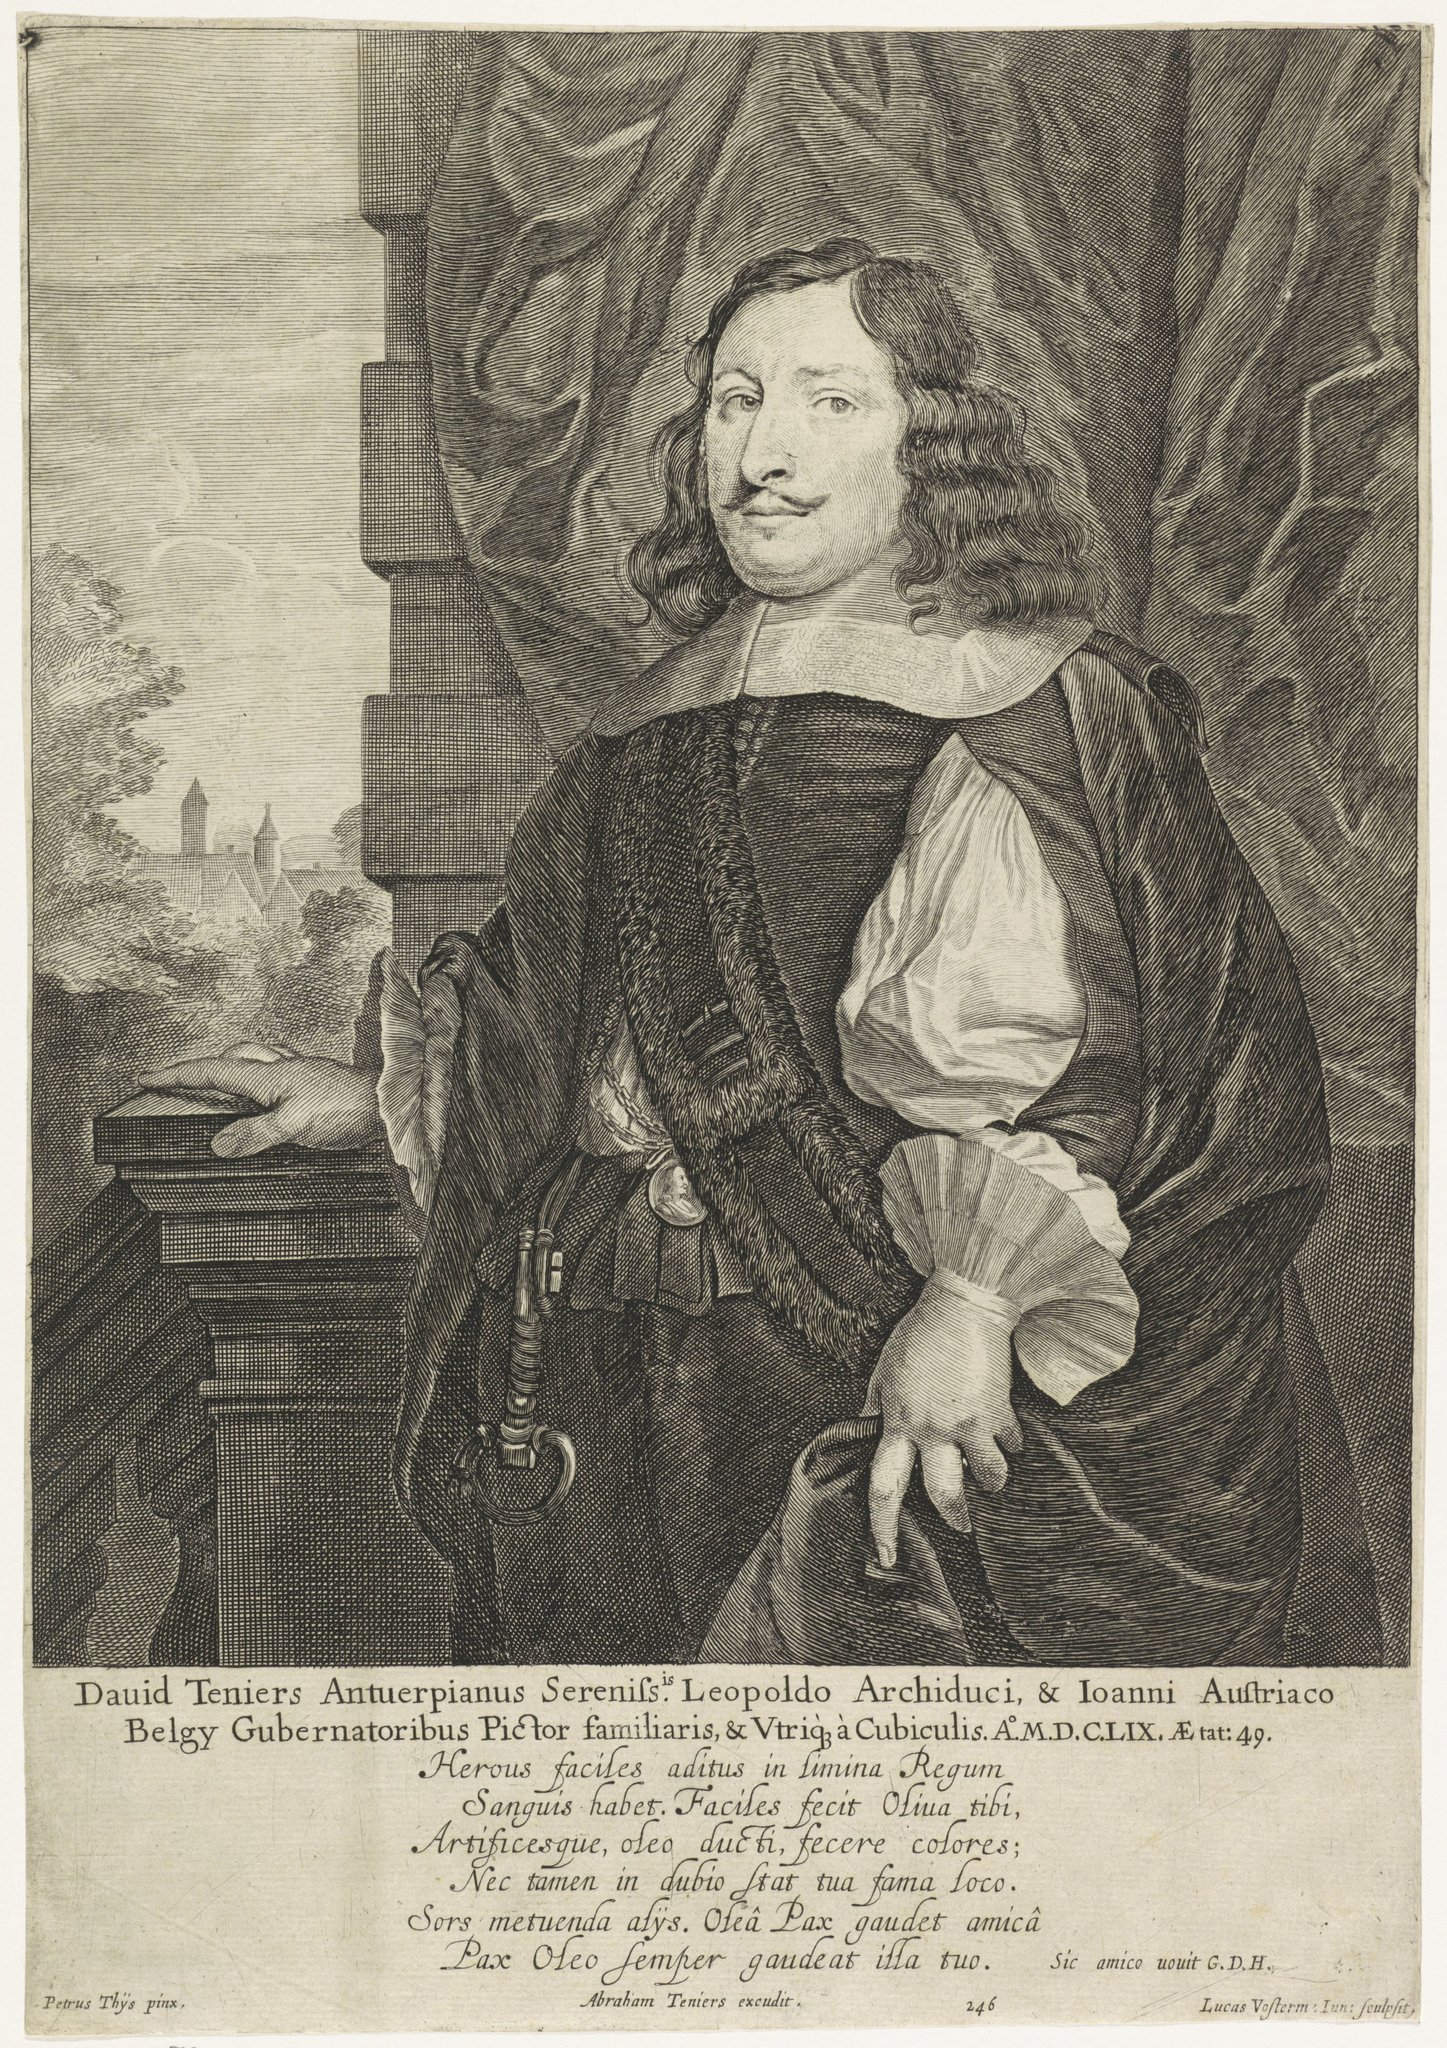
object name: print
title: Portret van David Teniers (II)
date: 1651-1670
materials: paper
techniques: engraving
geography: antwerp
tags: antwerp, brussels, painter, print maker, draughtsman, david teniers (ii)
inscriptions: collector's mark: Lugt 2228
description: Portret van de schilder en prentmaker David Teniers (II).